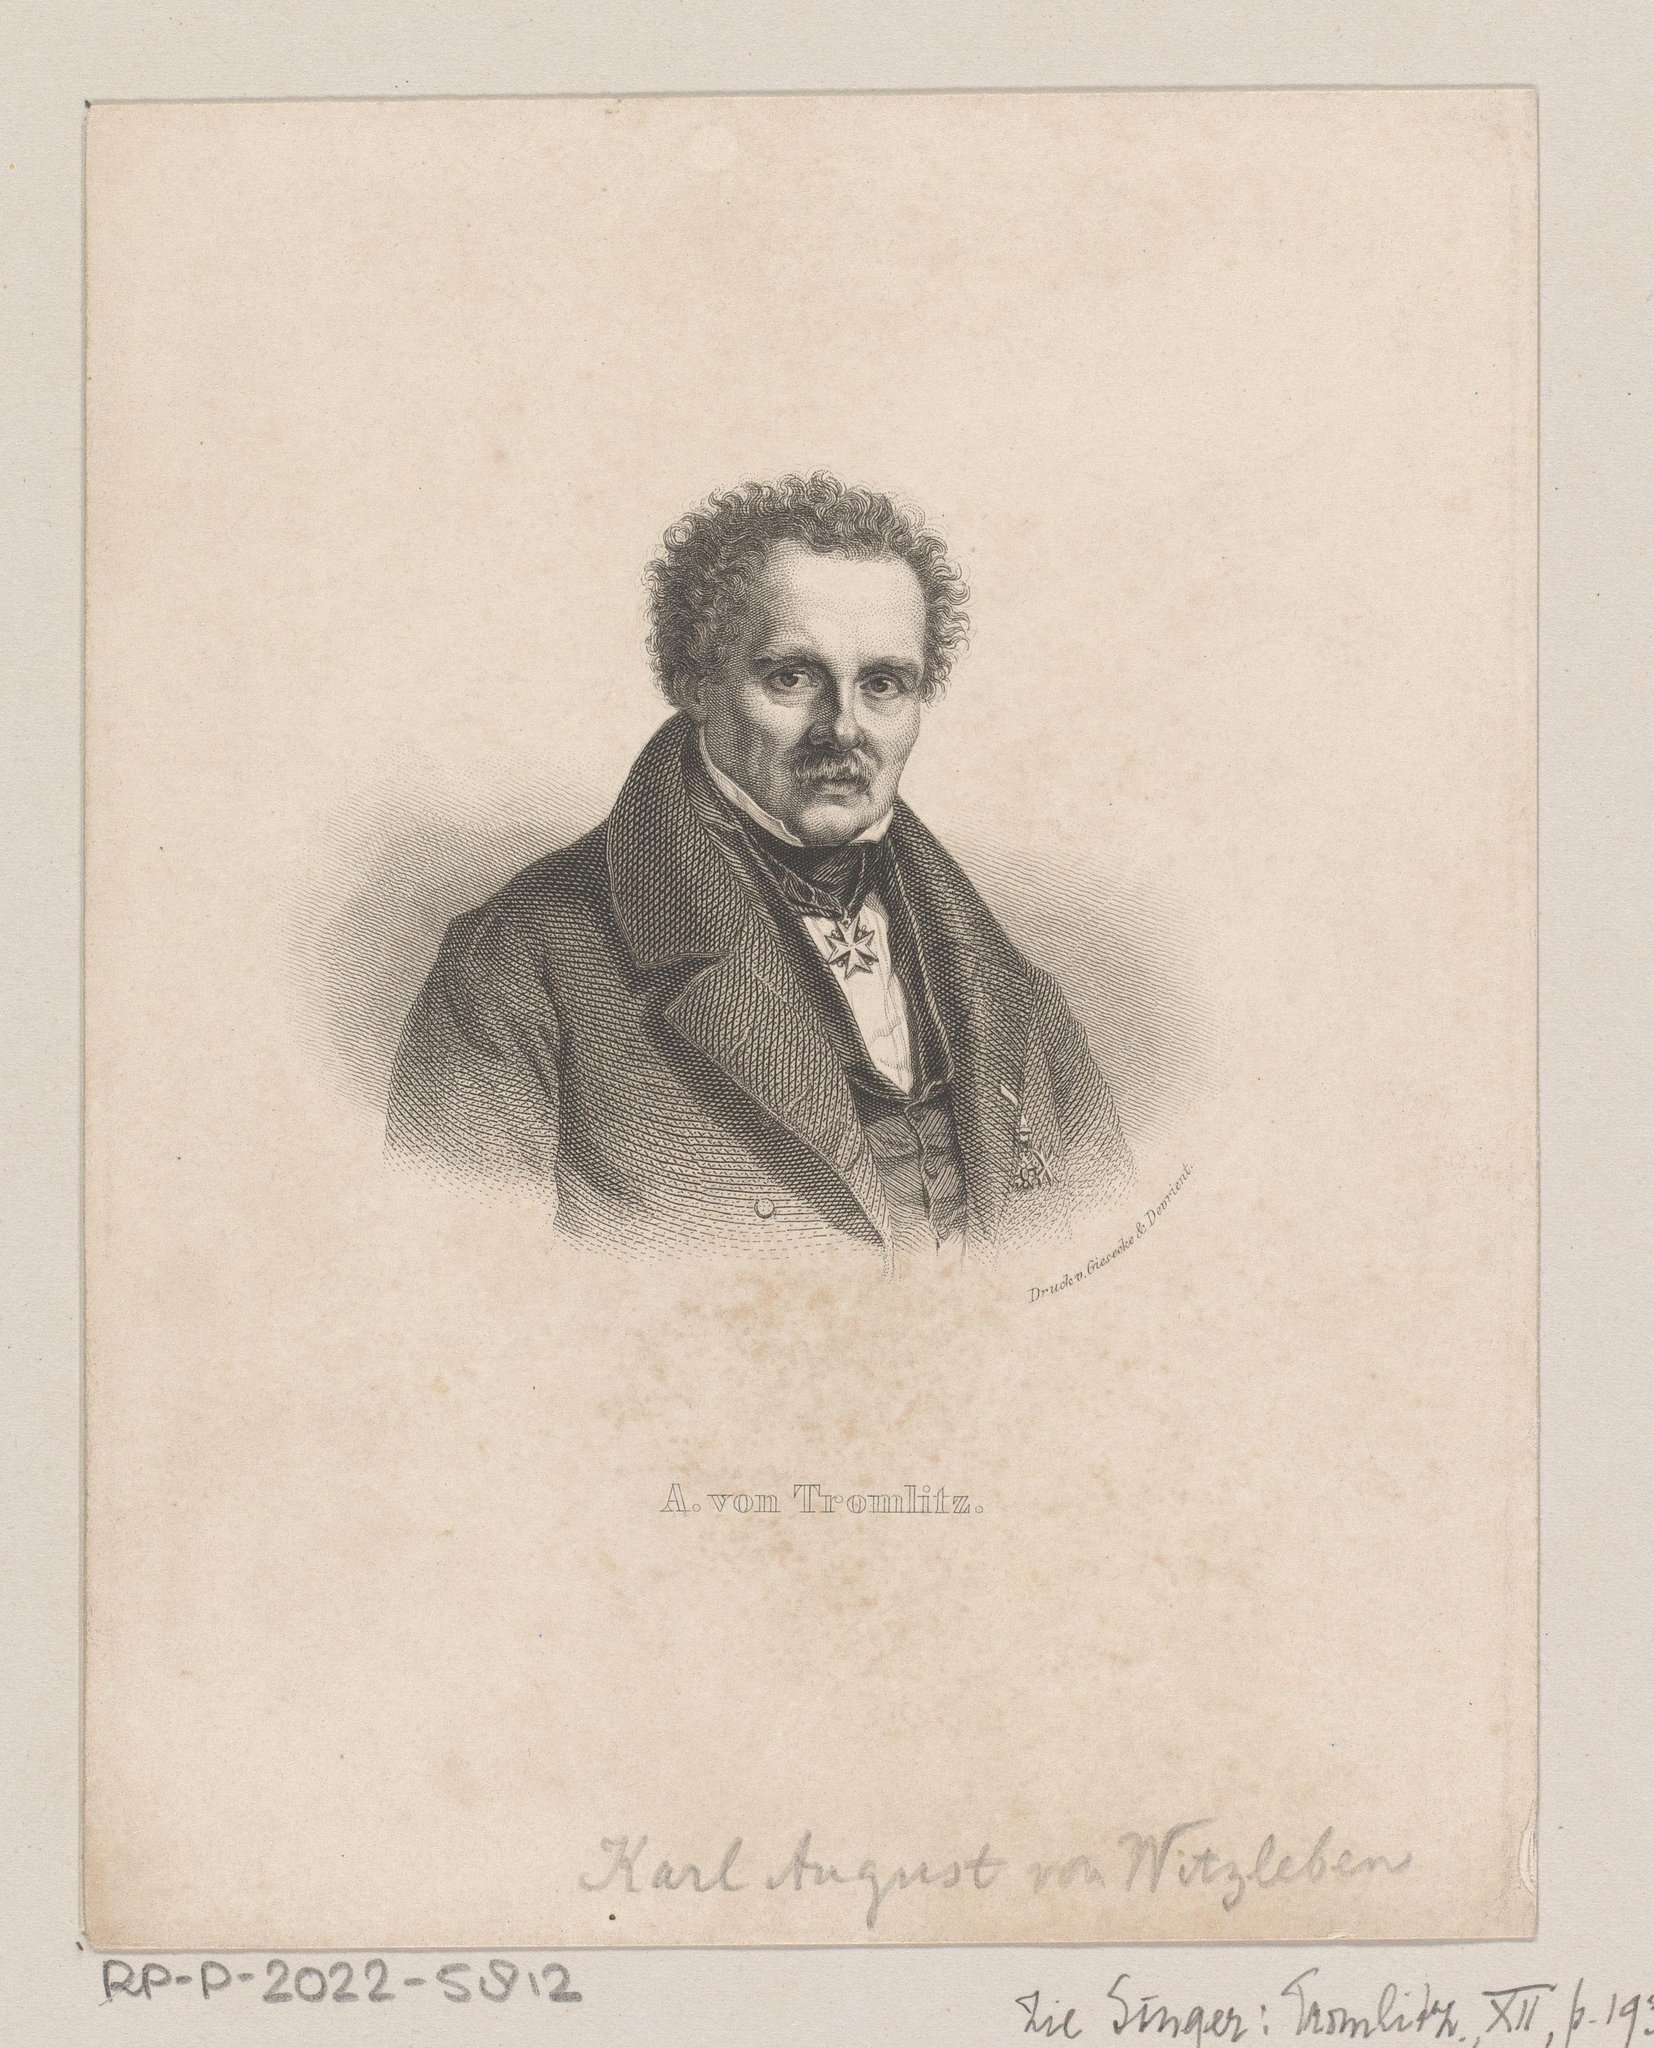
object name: print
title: Portret van Karl August Friedrich von Witzleben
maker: Anonymous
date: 1852-1900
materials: paper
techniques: engraving, etching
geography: leipzig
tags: historical persons, portrait of a writer